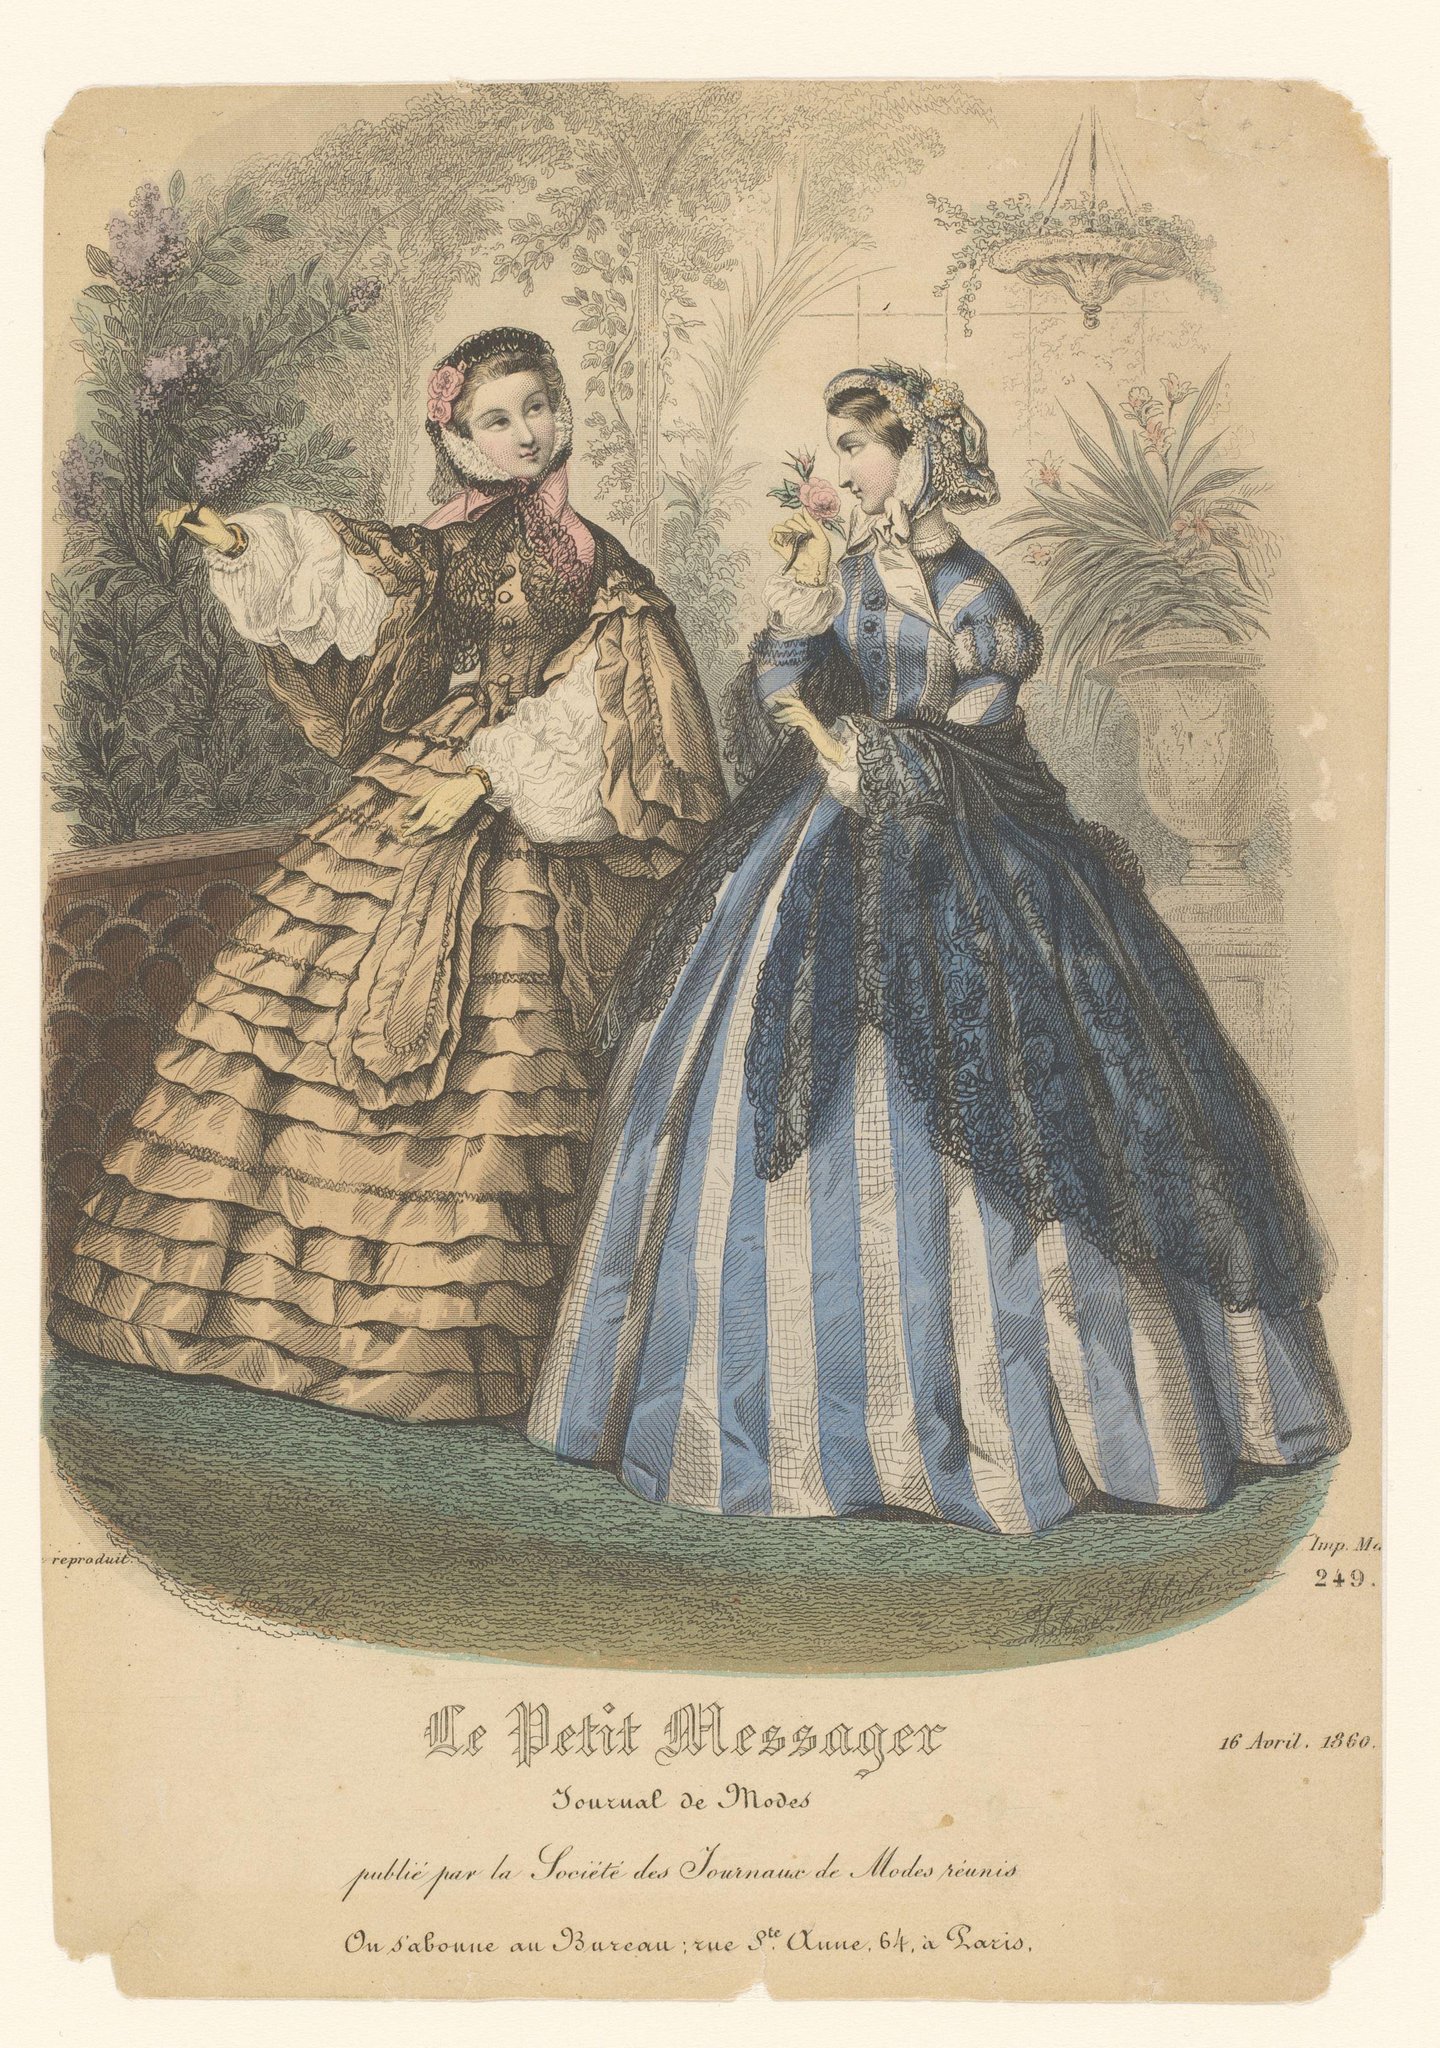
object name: print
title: Twee vrouwen in jurk en met kapje in een kas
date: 1860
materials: paper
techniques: etching, hand coloring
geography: paris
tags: flowers, clothing for the upper part of the body (shawl) (+ women's clothes), fashion plates, head-gear: hat (+ women's clothes), dress, gown (+ women's clothes), smell, smelling (one of the five senses) - aa - female human figure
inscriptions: collector's mark: Lugt 2166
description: Prent uit: Le Petit Messager (1860), 16 april 1860.